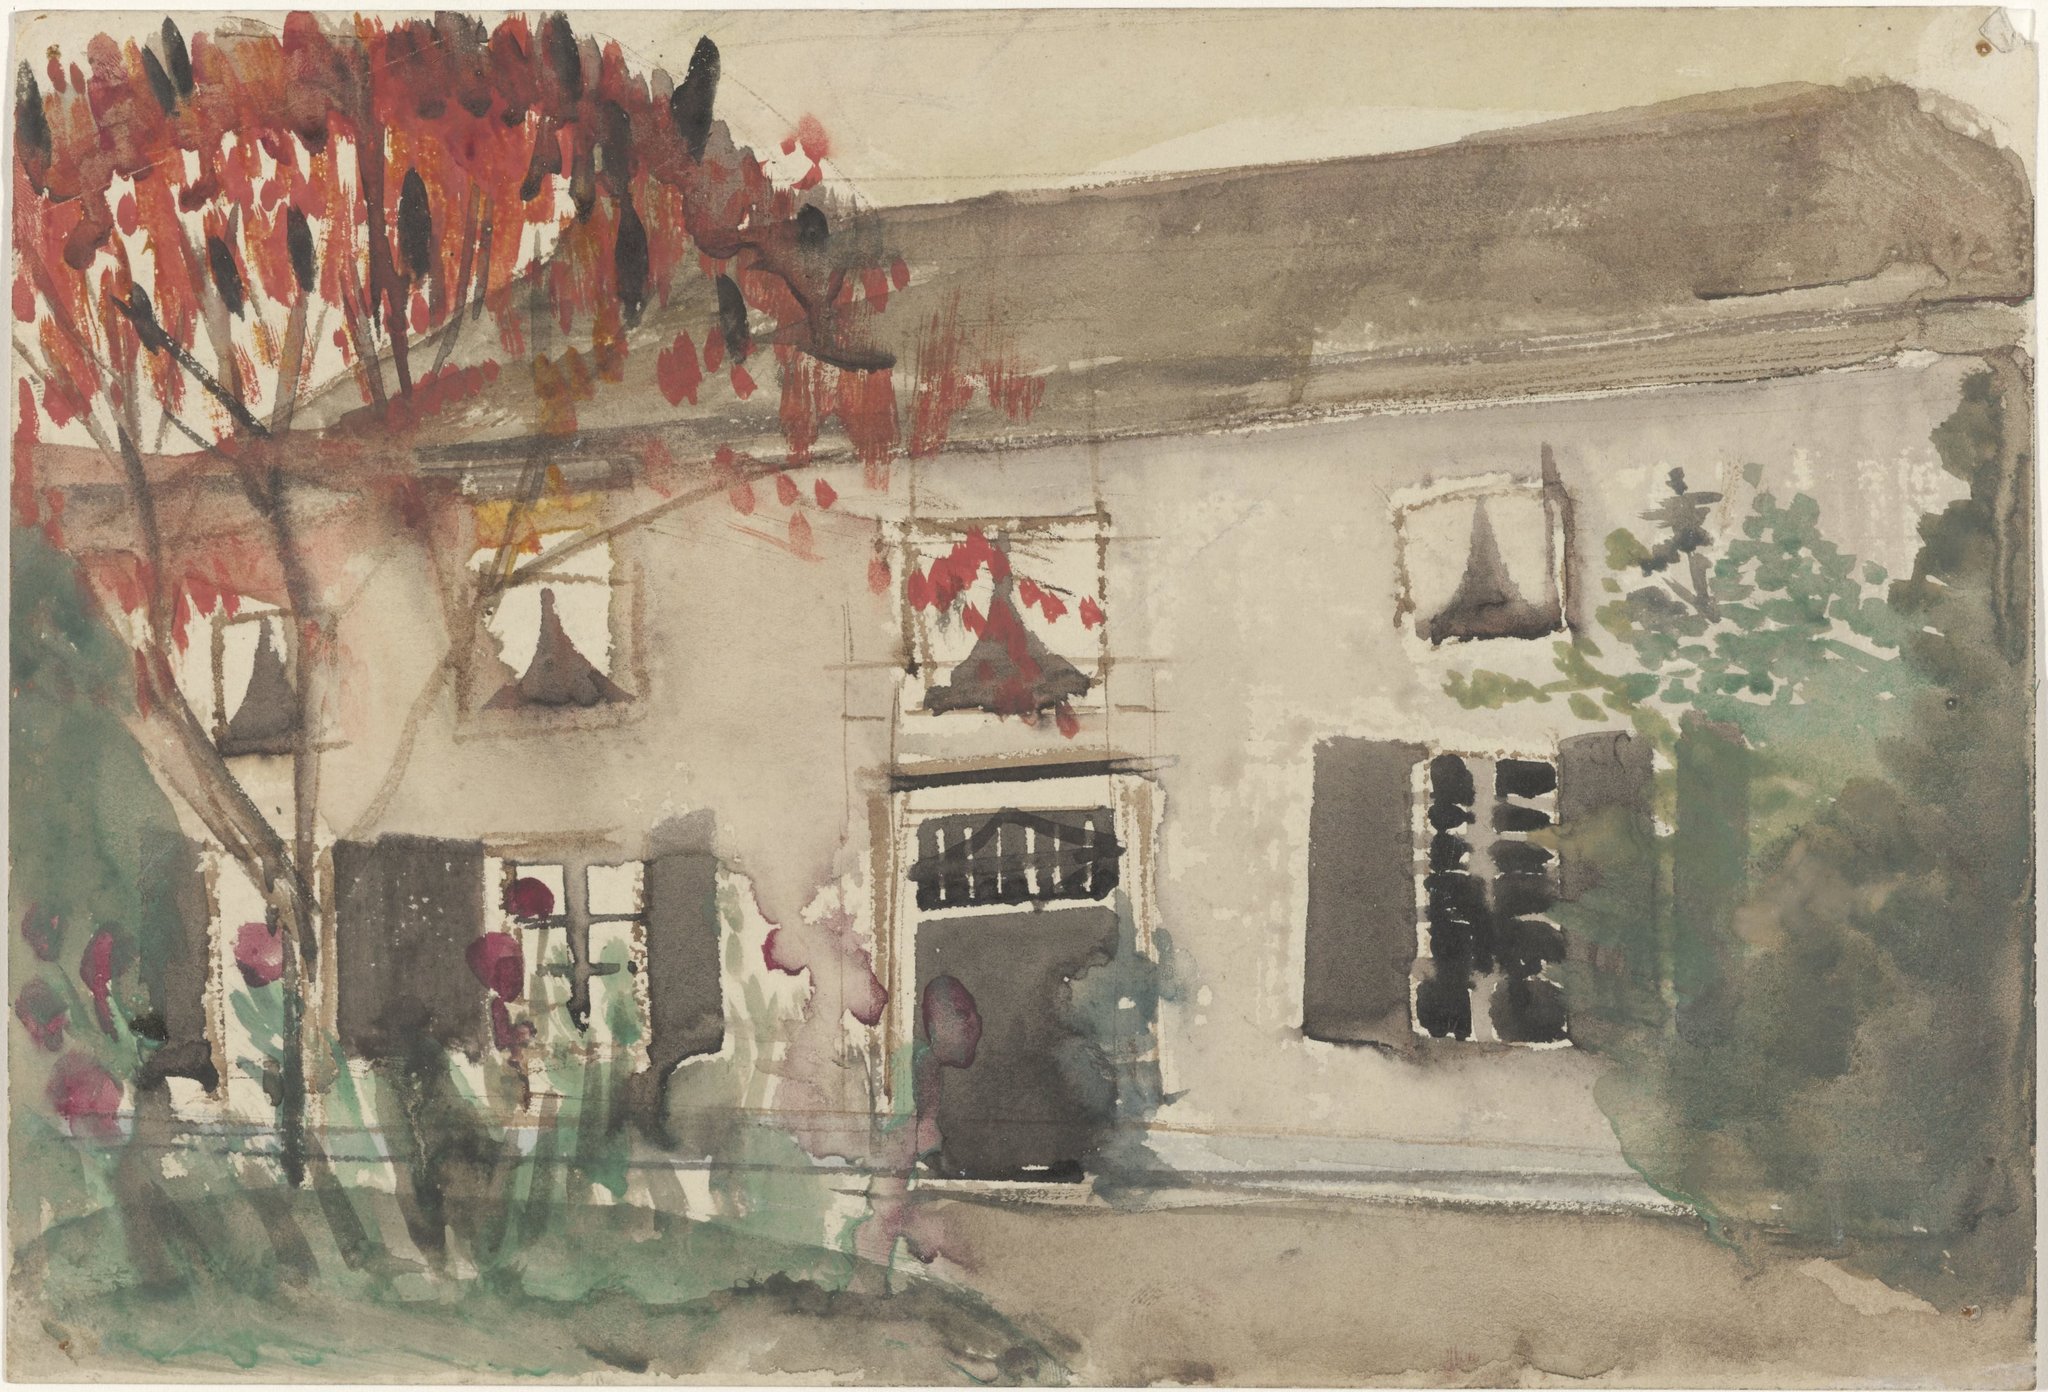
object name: drawing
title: Huis met voortuin en rode boom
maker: carel adolph lion cachet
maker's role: draughtsman, print maker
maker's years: 1864-1945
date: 1874-1945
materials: paper, watercolor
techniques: brush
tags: urban housing